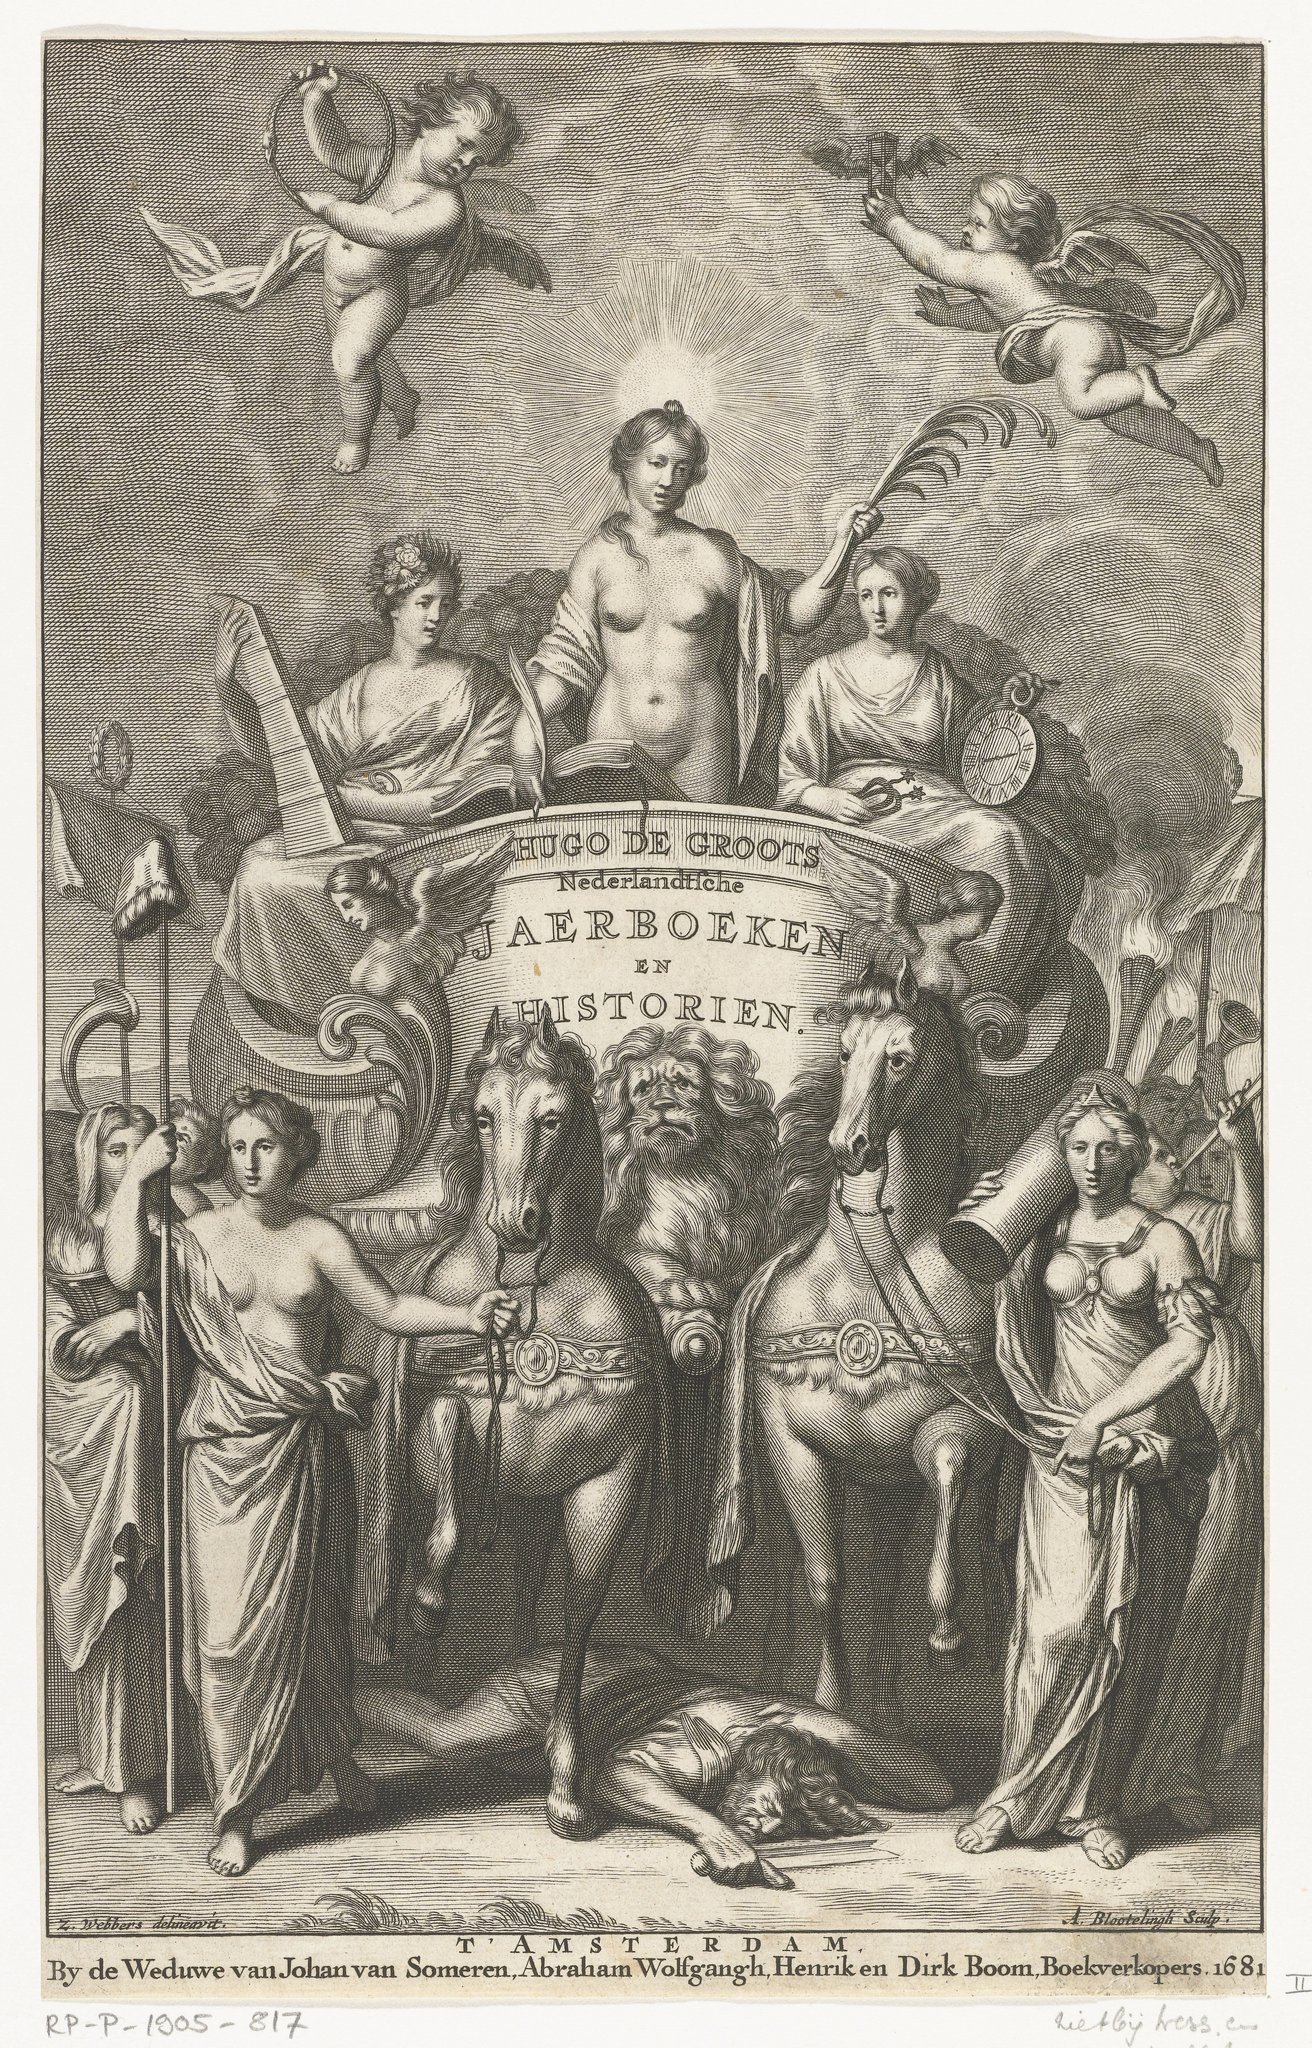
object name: titelblad, titelpagina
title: Titelpagina voor Hugo de Groots Nederlandtsche Jaerboeken en Historien, 1681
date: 1679-1681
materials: paper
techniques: engraving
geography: amsterdam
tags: chariot, triumphal car, truth; 'verità' (ripa), 'historia'; 'historia' (ripa)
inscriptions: collector's mark: Lugt 2228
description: Titelpagina voor: Hugo de Groot, Nederlandtsche jaerboeken en historien, sedert het jaer 1555 tot het jaer 1609, Amsterdam 1681. Staat met de letter.